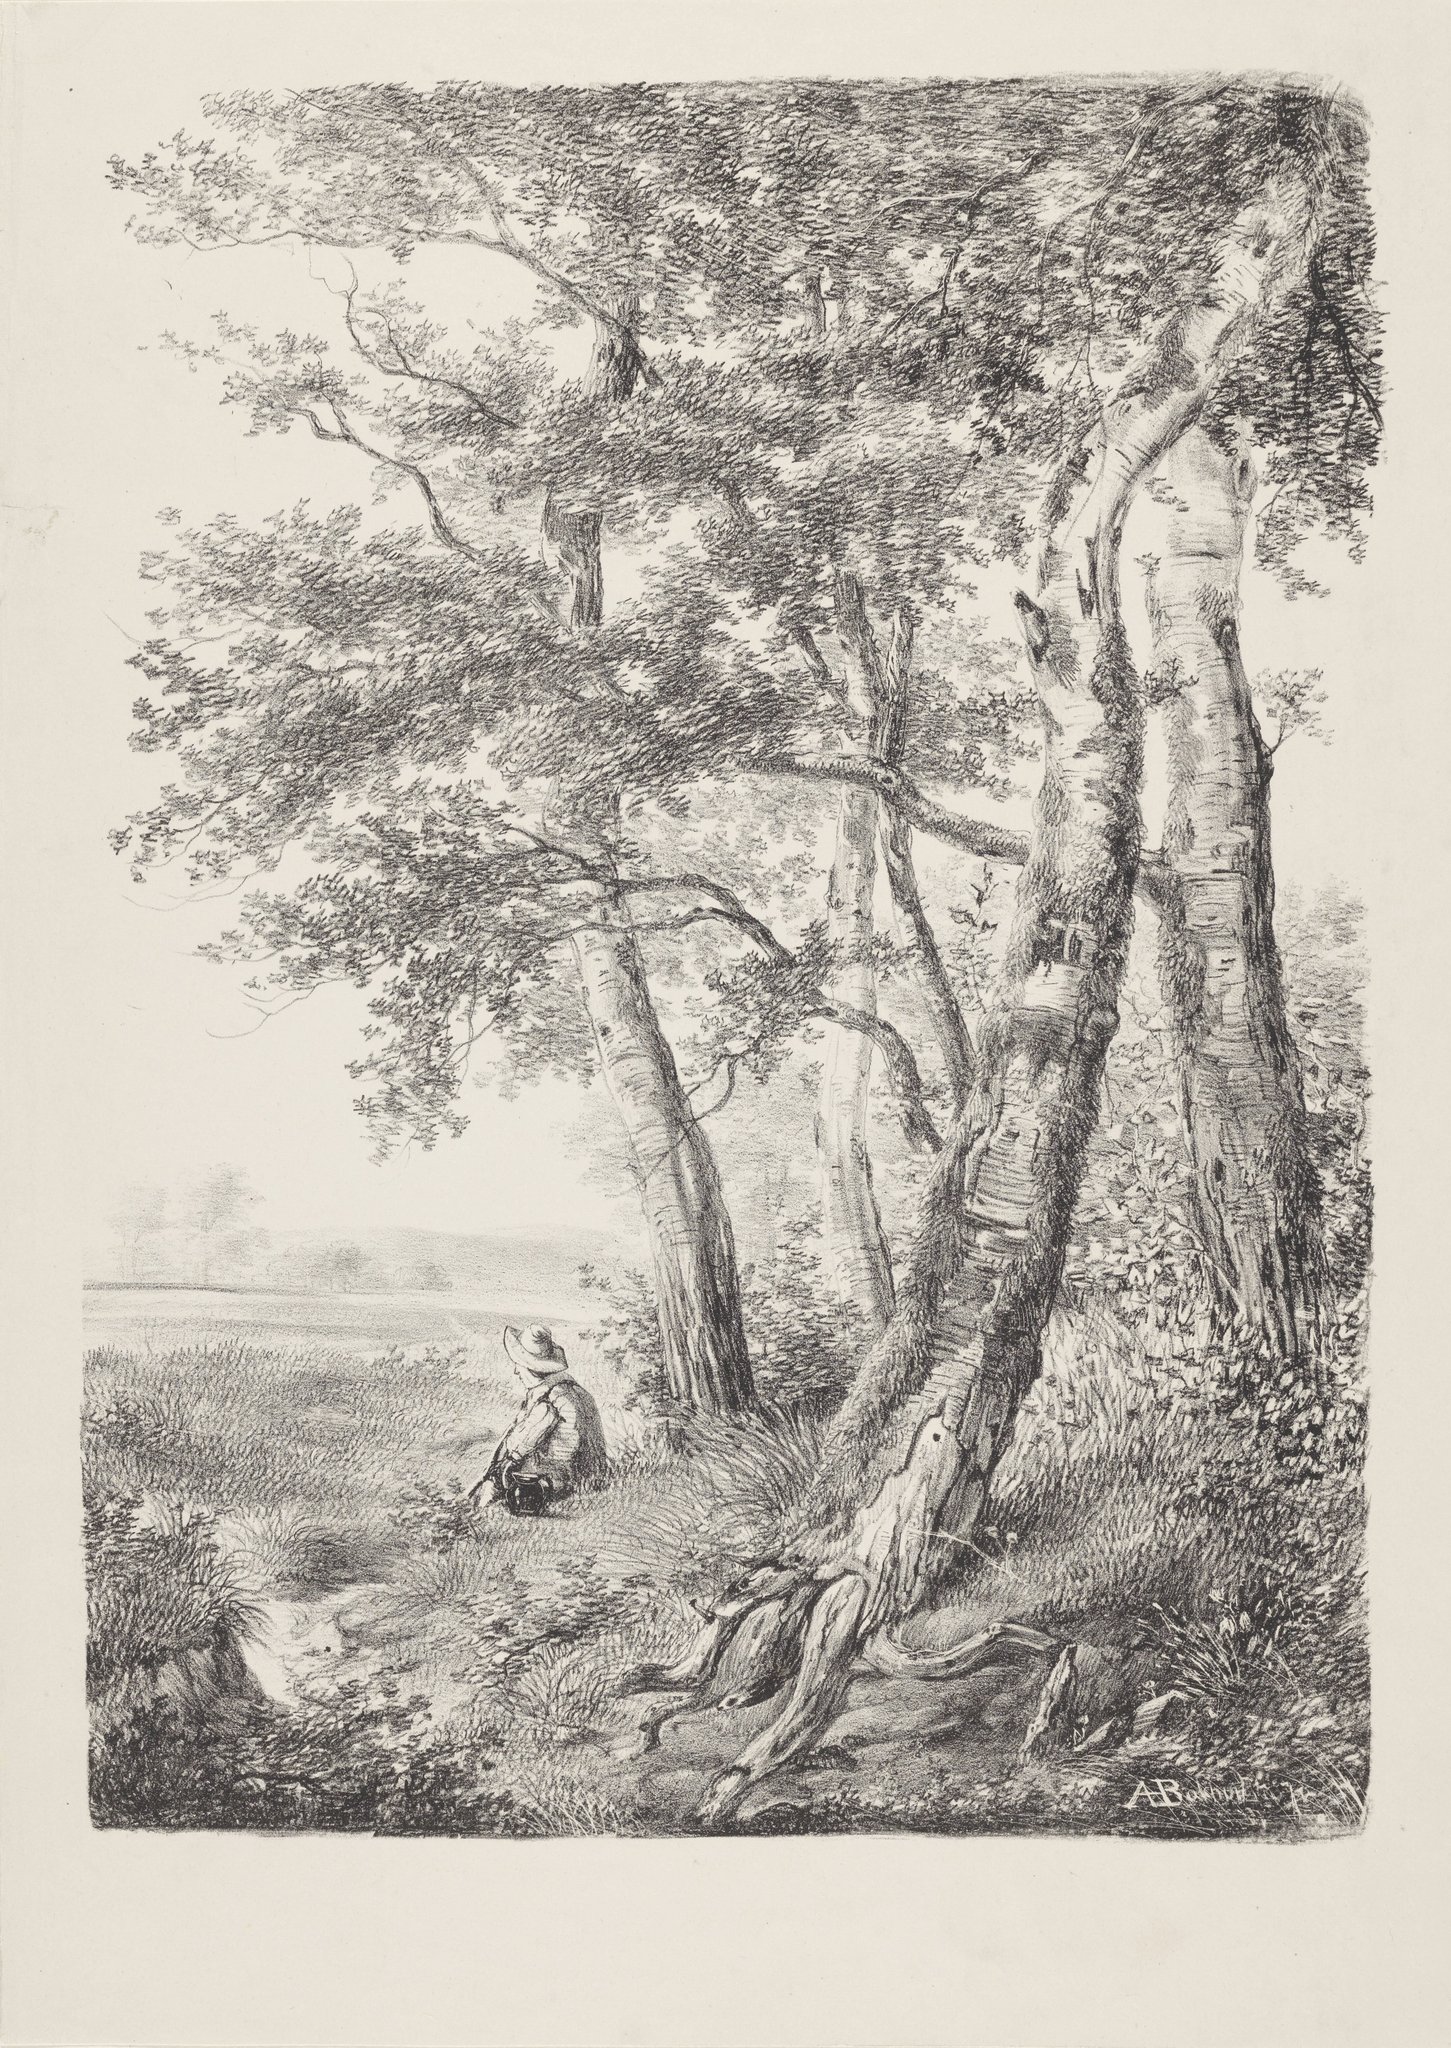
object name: print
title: Zittende figuur in landschap met bomen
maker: alexander hieronymus bakhuyzen (ii)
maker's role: print maker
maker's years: 1826-1878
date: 1836-1878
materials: paper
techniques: lithography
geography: netherlands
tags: meadow, pasture, groups of trees, trees: birch, sitting on the ground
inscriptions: collector's mark: Lugt 2228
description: Een figuur zit onder een groep bomen en kijkt uit over een weiland. Naast hem staat een kruik.